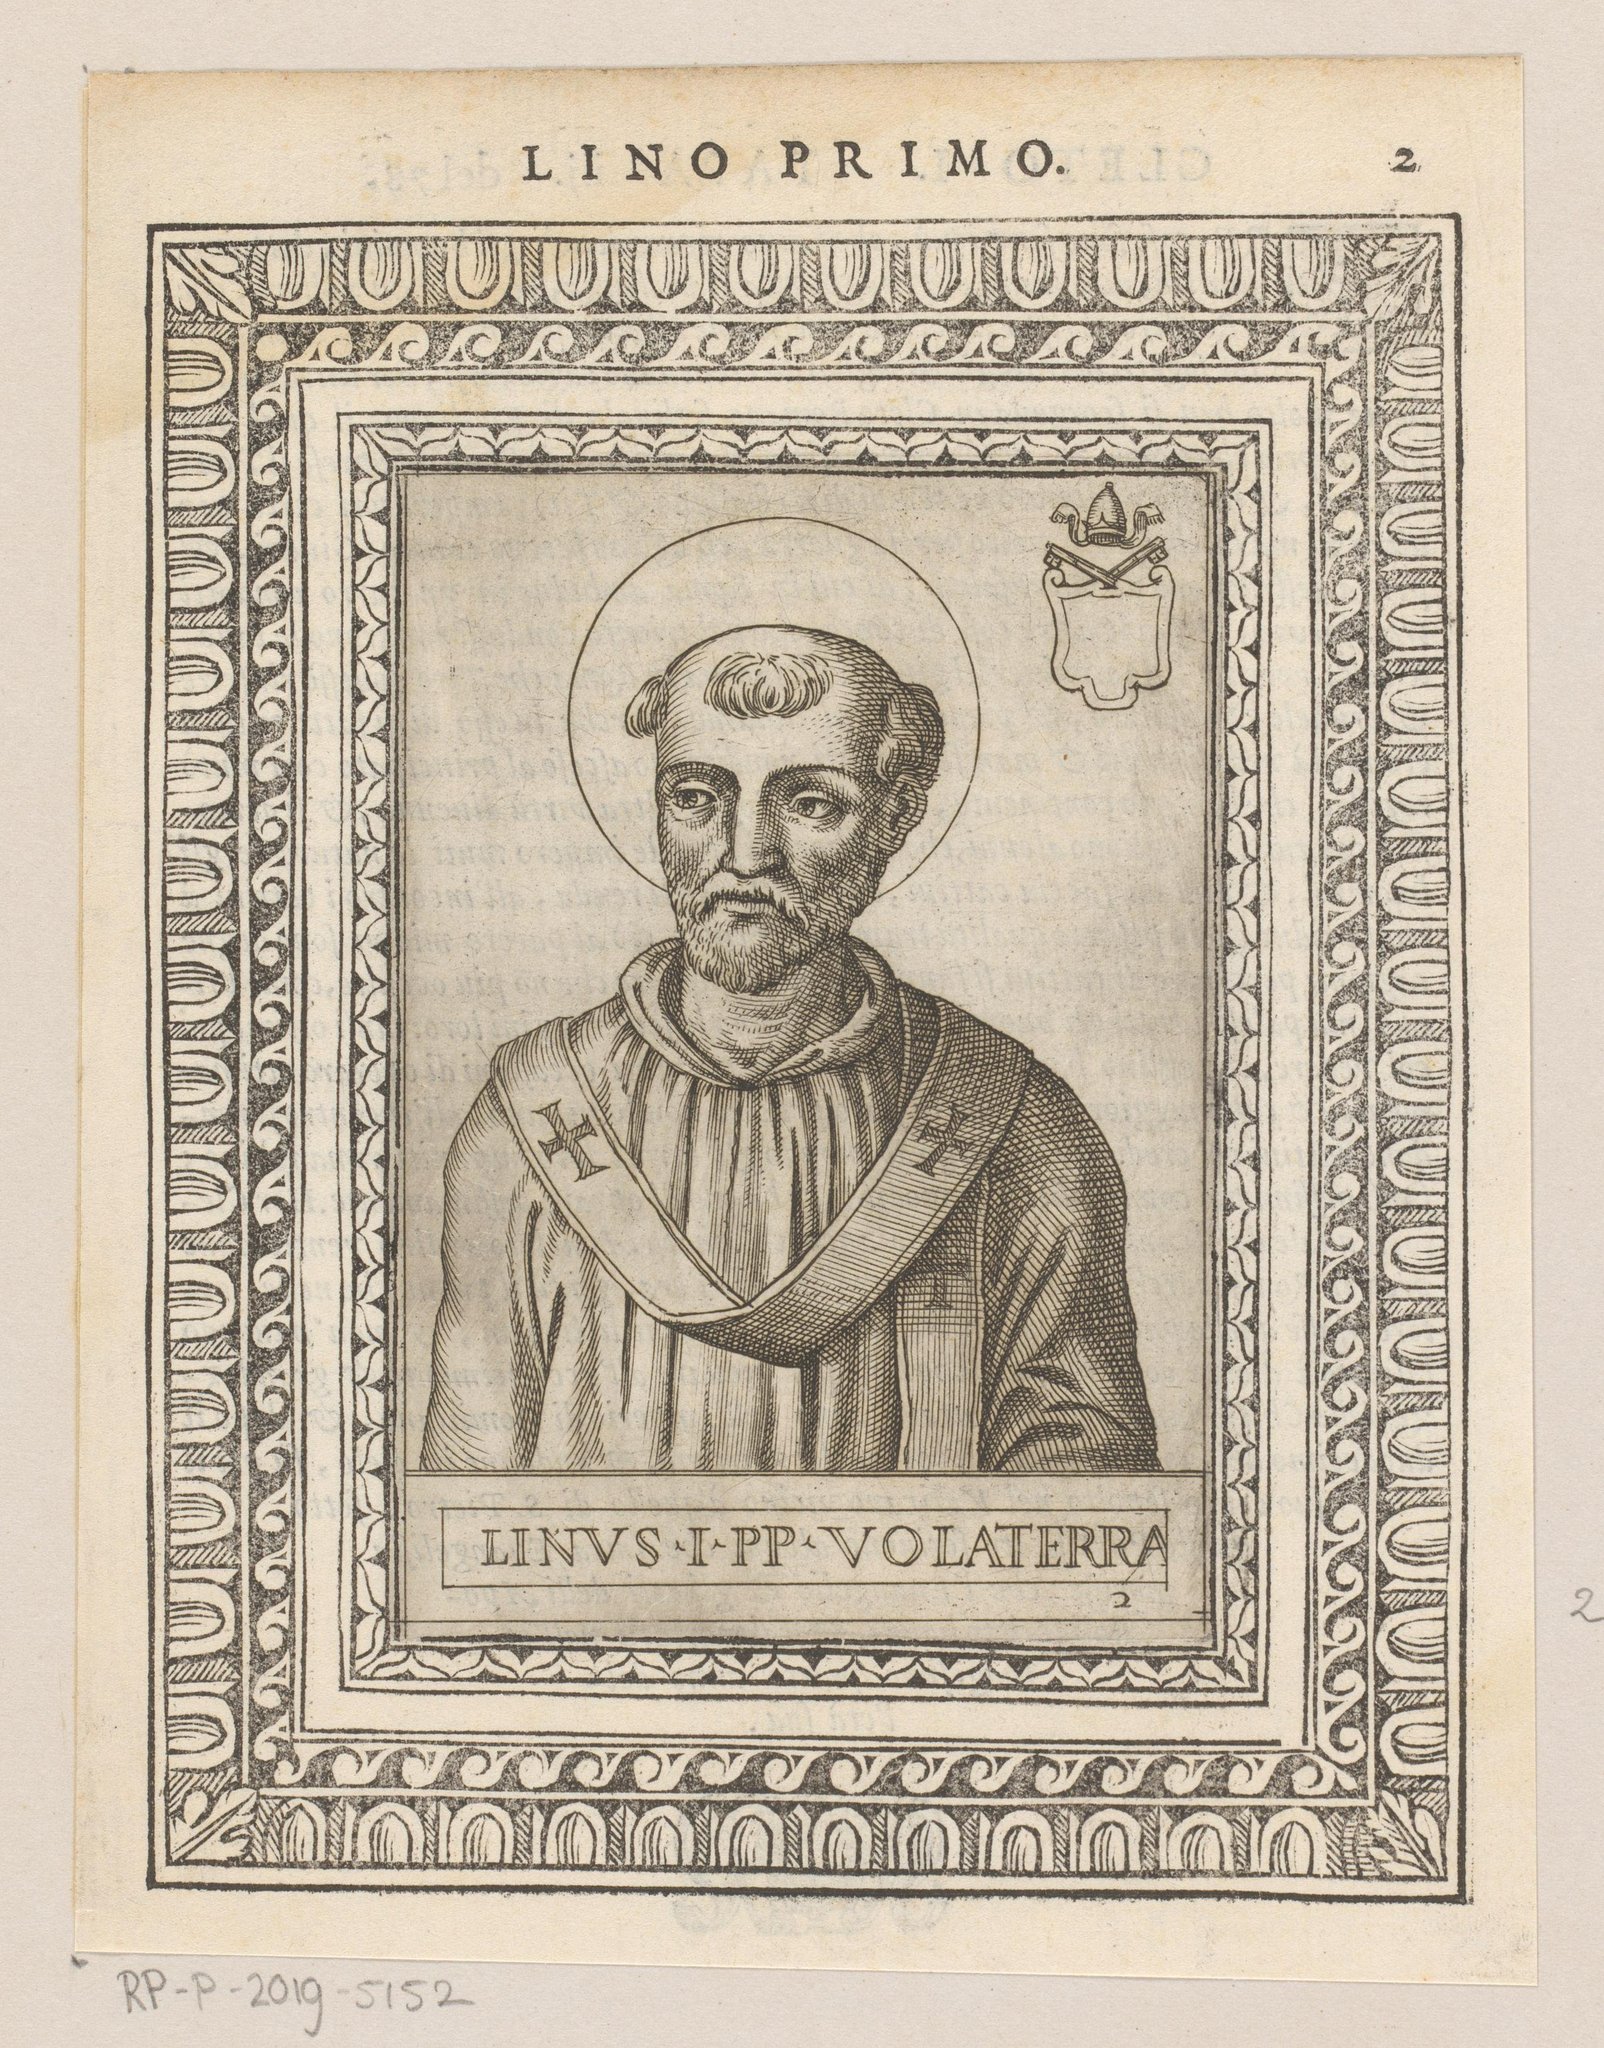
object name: print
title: Portret van paus Linus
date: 1587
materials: paper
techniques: engraving, letterpress printing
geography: rome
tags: priest, historical persons, pope, armorial bearing, heraldry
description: Prent uit: Ciccarelli, Antonio. Le vite de Pontefici di Antonio Ciccarelli (...). Rome: Domenico Basa, 1587. Prent voor het eerst verschenen in: Cavalieri, Giovanni Battista de'. Pontificum romanorum effigies (...). Rome: Domenico Basa en Francesco Zanetti, 1580. Prent ook gebruikt in latere publicaties.